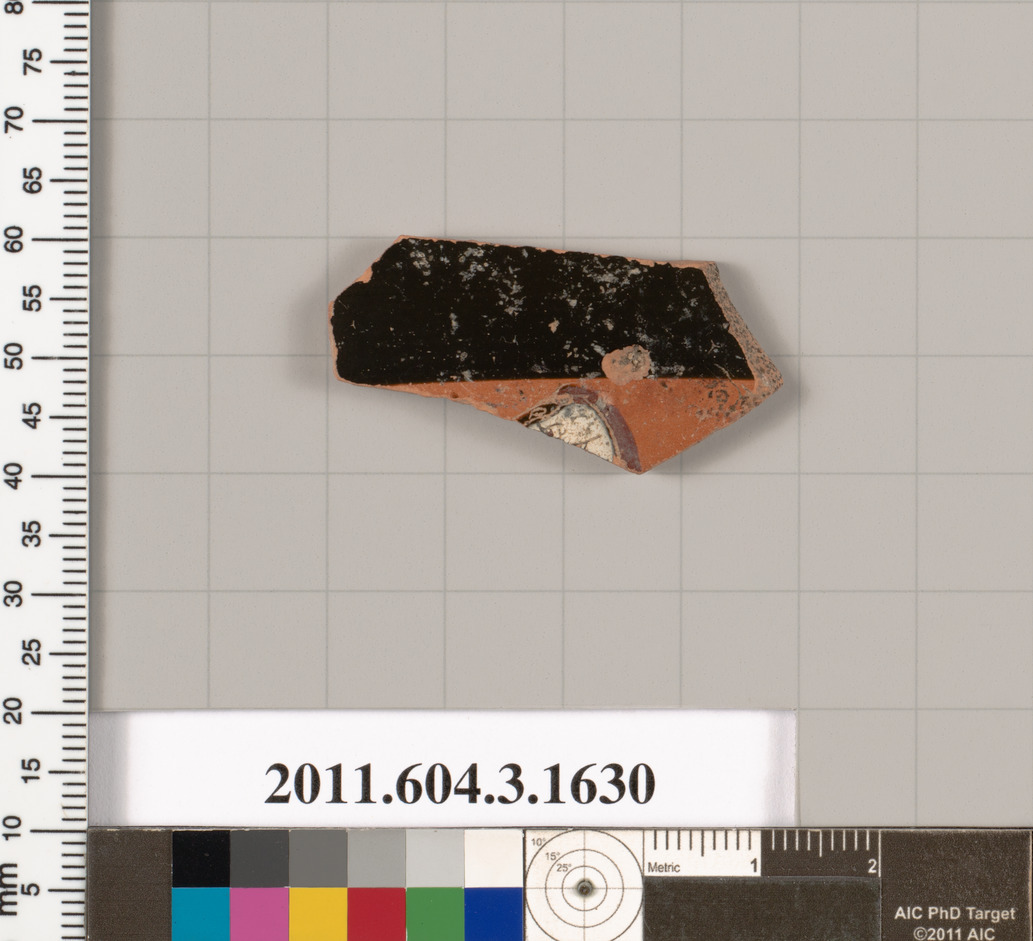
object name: kylix fragment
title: Terracotta fragment of a kylix: Band cup (drinking cup)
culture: greek, attic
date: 567-535 BCE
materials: terracotta